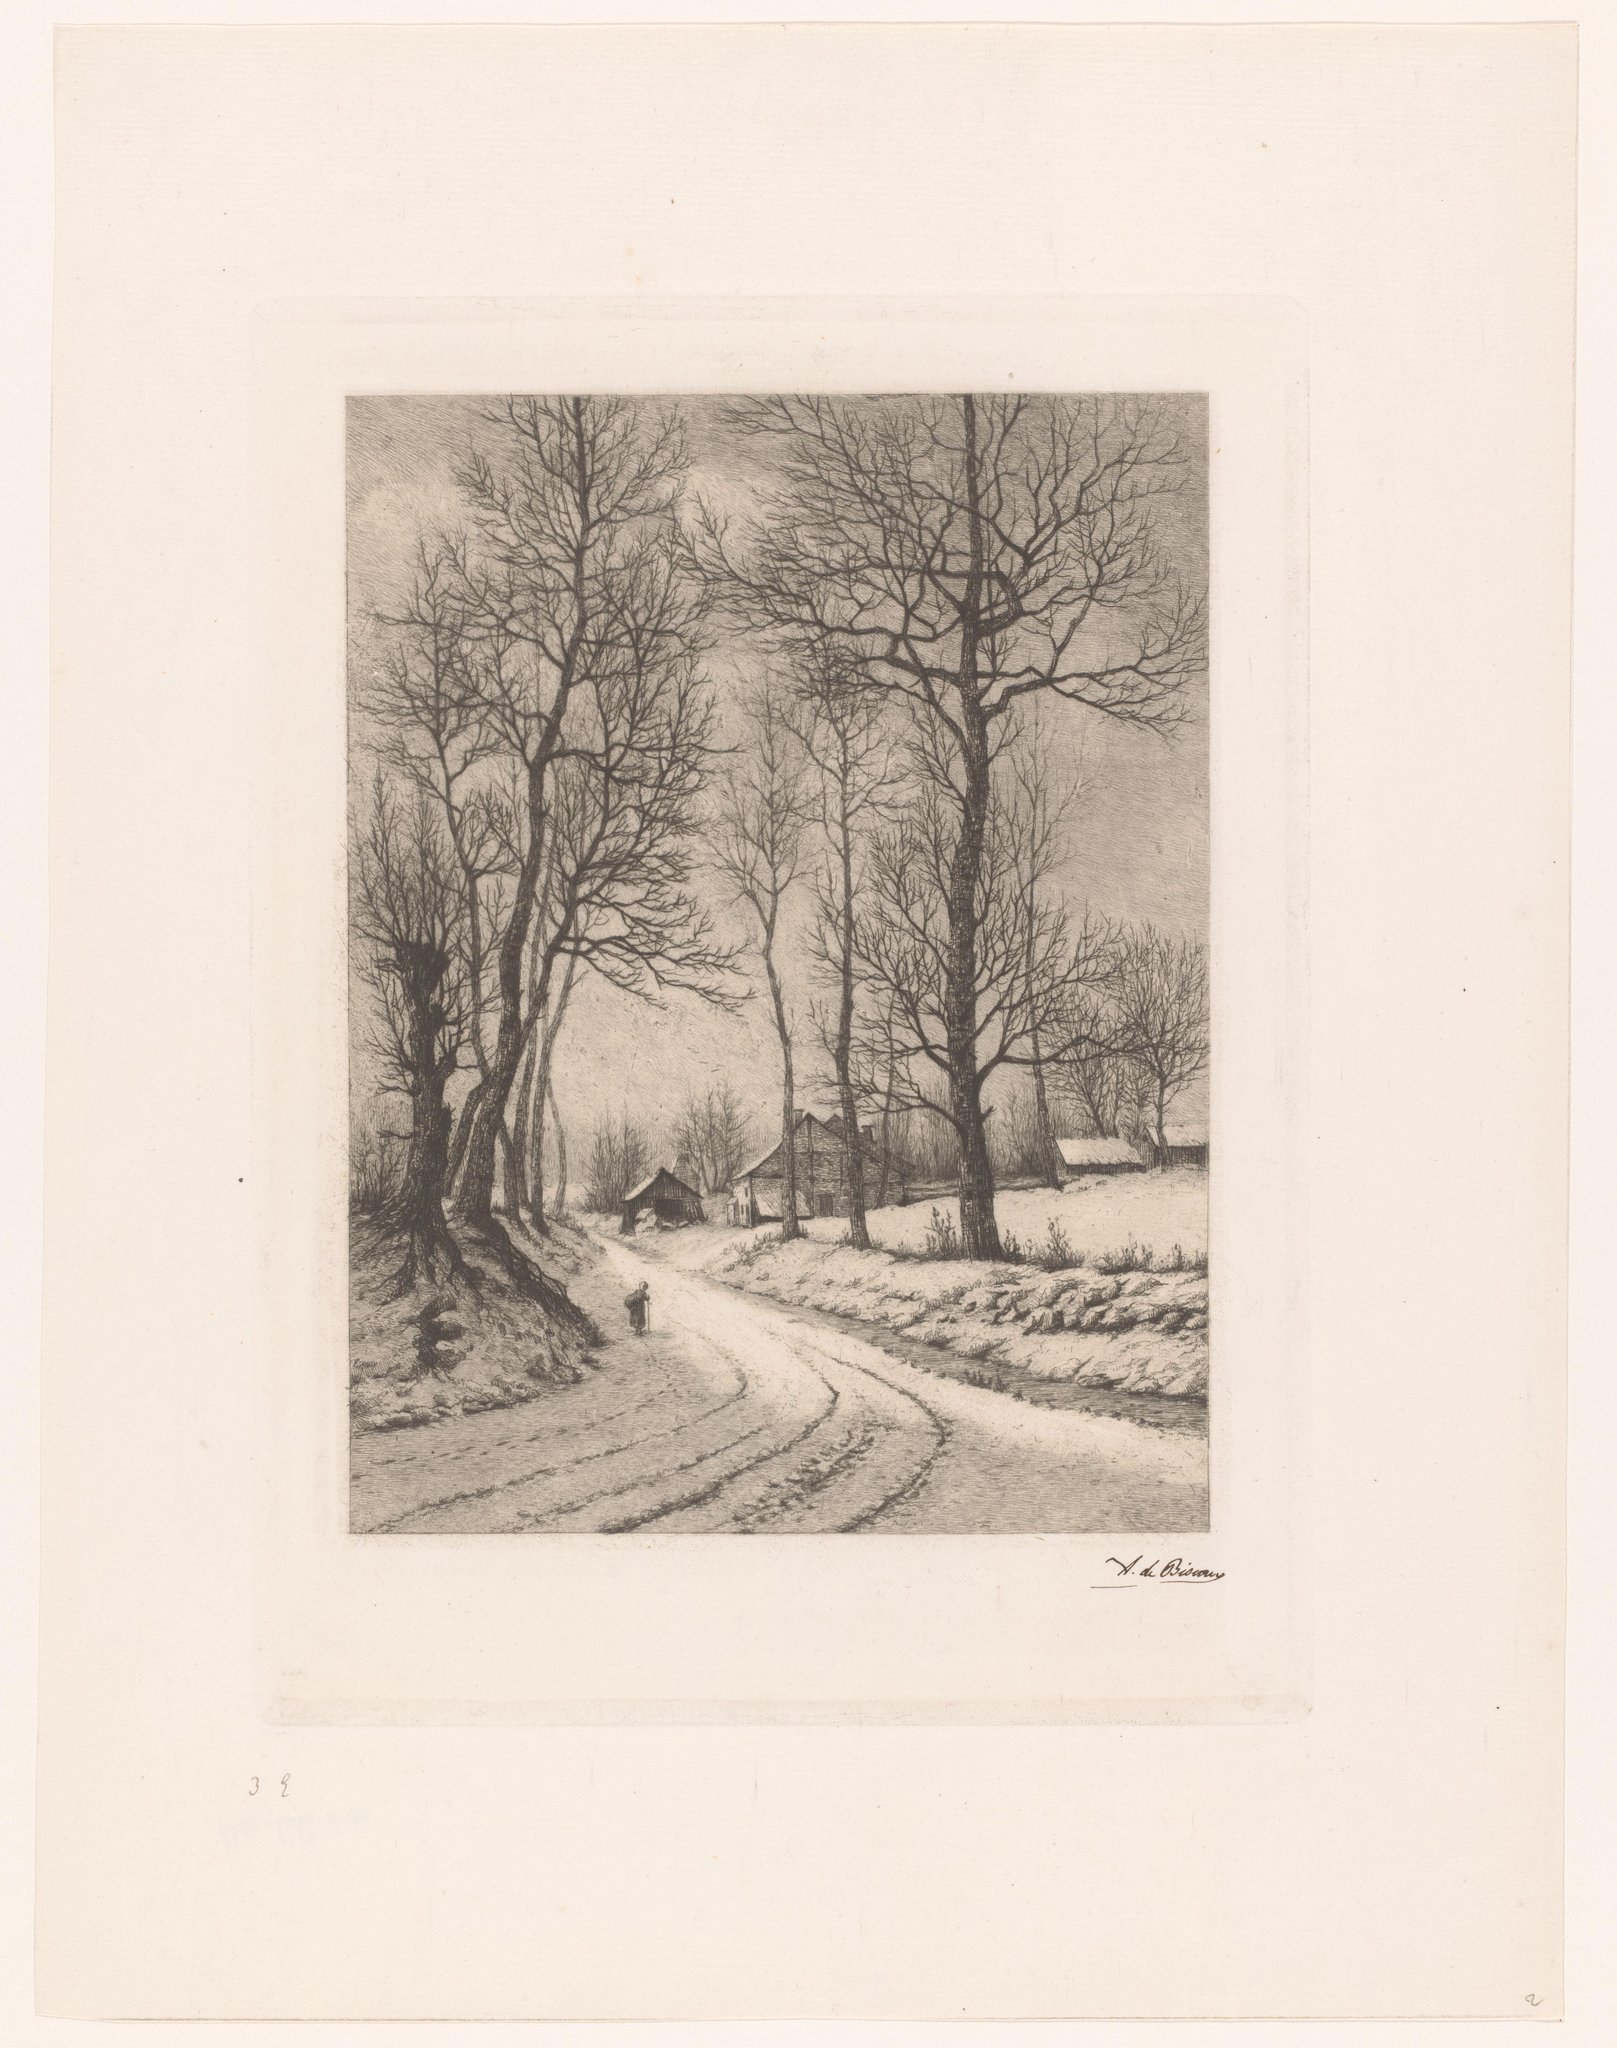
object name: print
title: Winterlandschap nabij Oudergem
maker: aristide de biseau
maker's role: print maker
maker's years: 1844-1883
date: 1854-1883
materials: paper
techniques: etching, intaglio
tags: forest path or lane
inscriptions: watermark: ‘Dambricourt Frères’, collector's mark: Lugt 2228